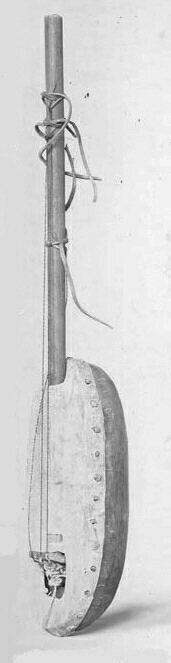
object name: hoddu xalam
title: Hoddu (Xalam)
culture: fulbe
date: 1867-1900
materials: skin, wood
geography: mali